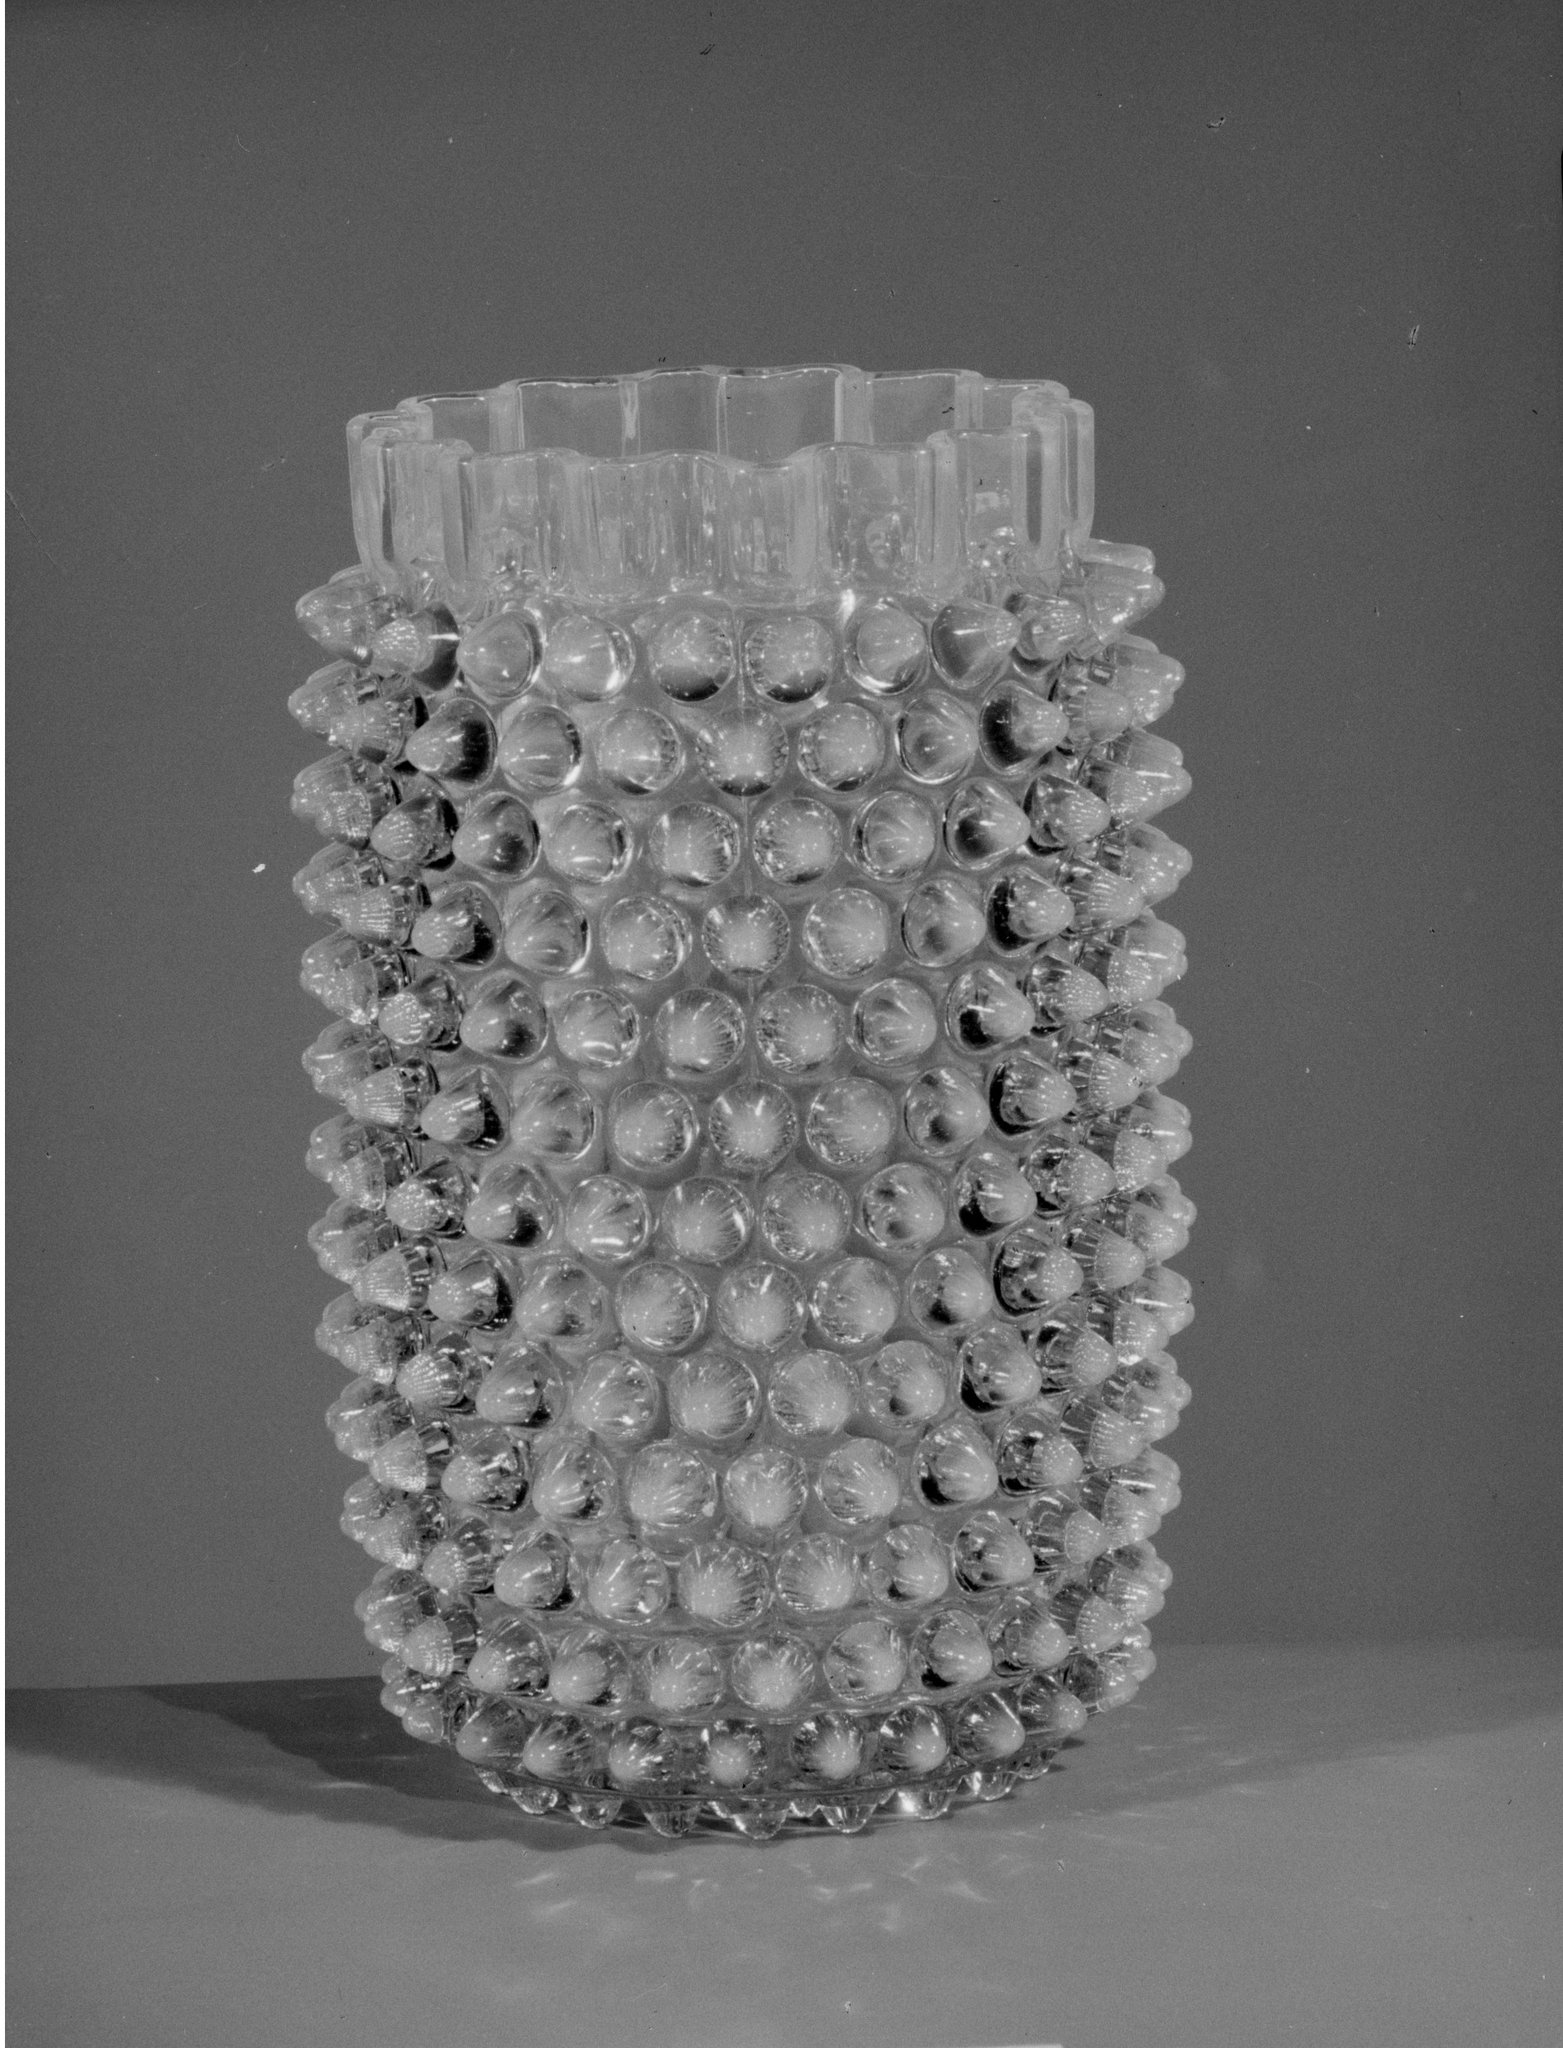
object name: celery vase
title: Hobnail celery vase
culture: american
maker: hobbs, brockunier and company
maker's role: maker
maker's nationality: american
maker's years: 1863-1891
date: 1886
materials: glass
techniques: pressed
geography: united states